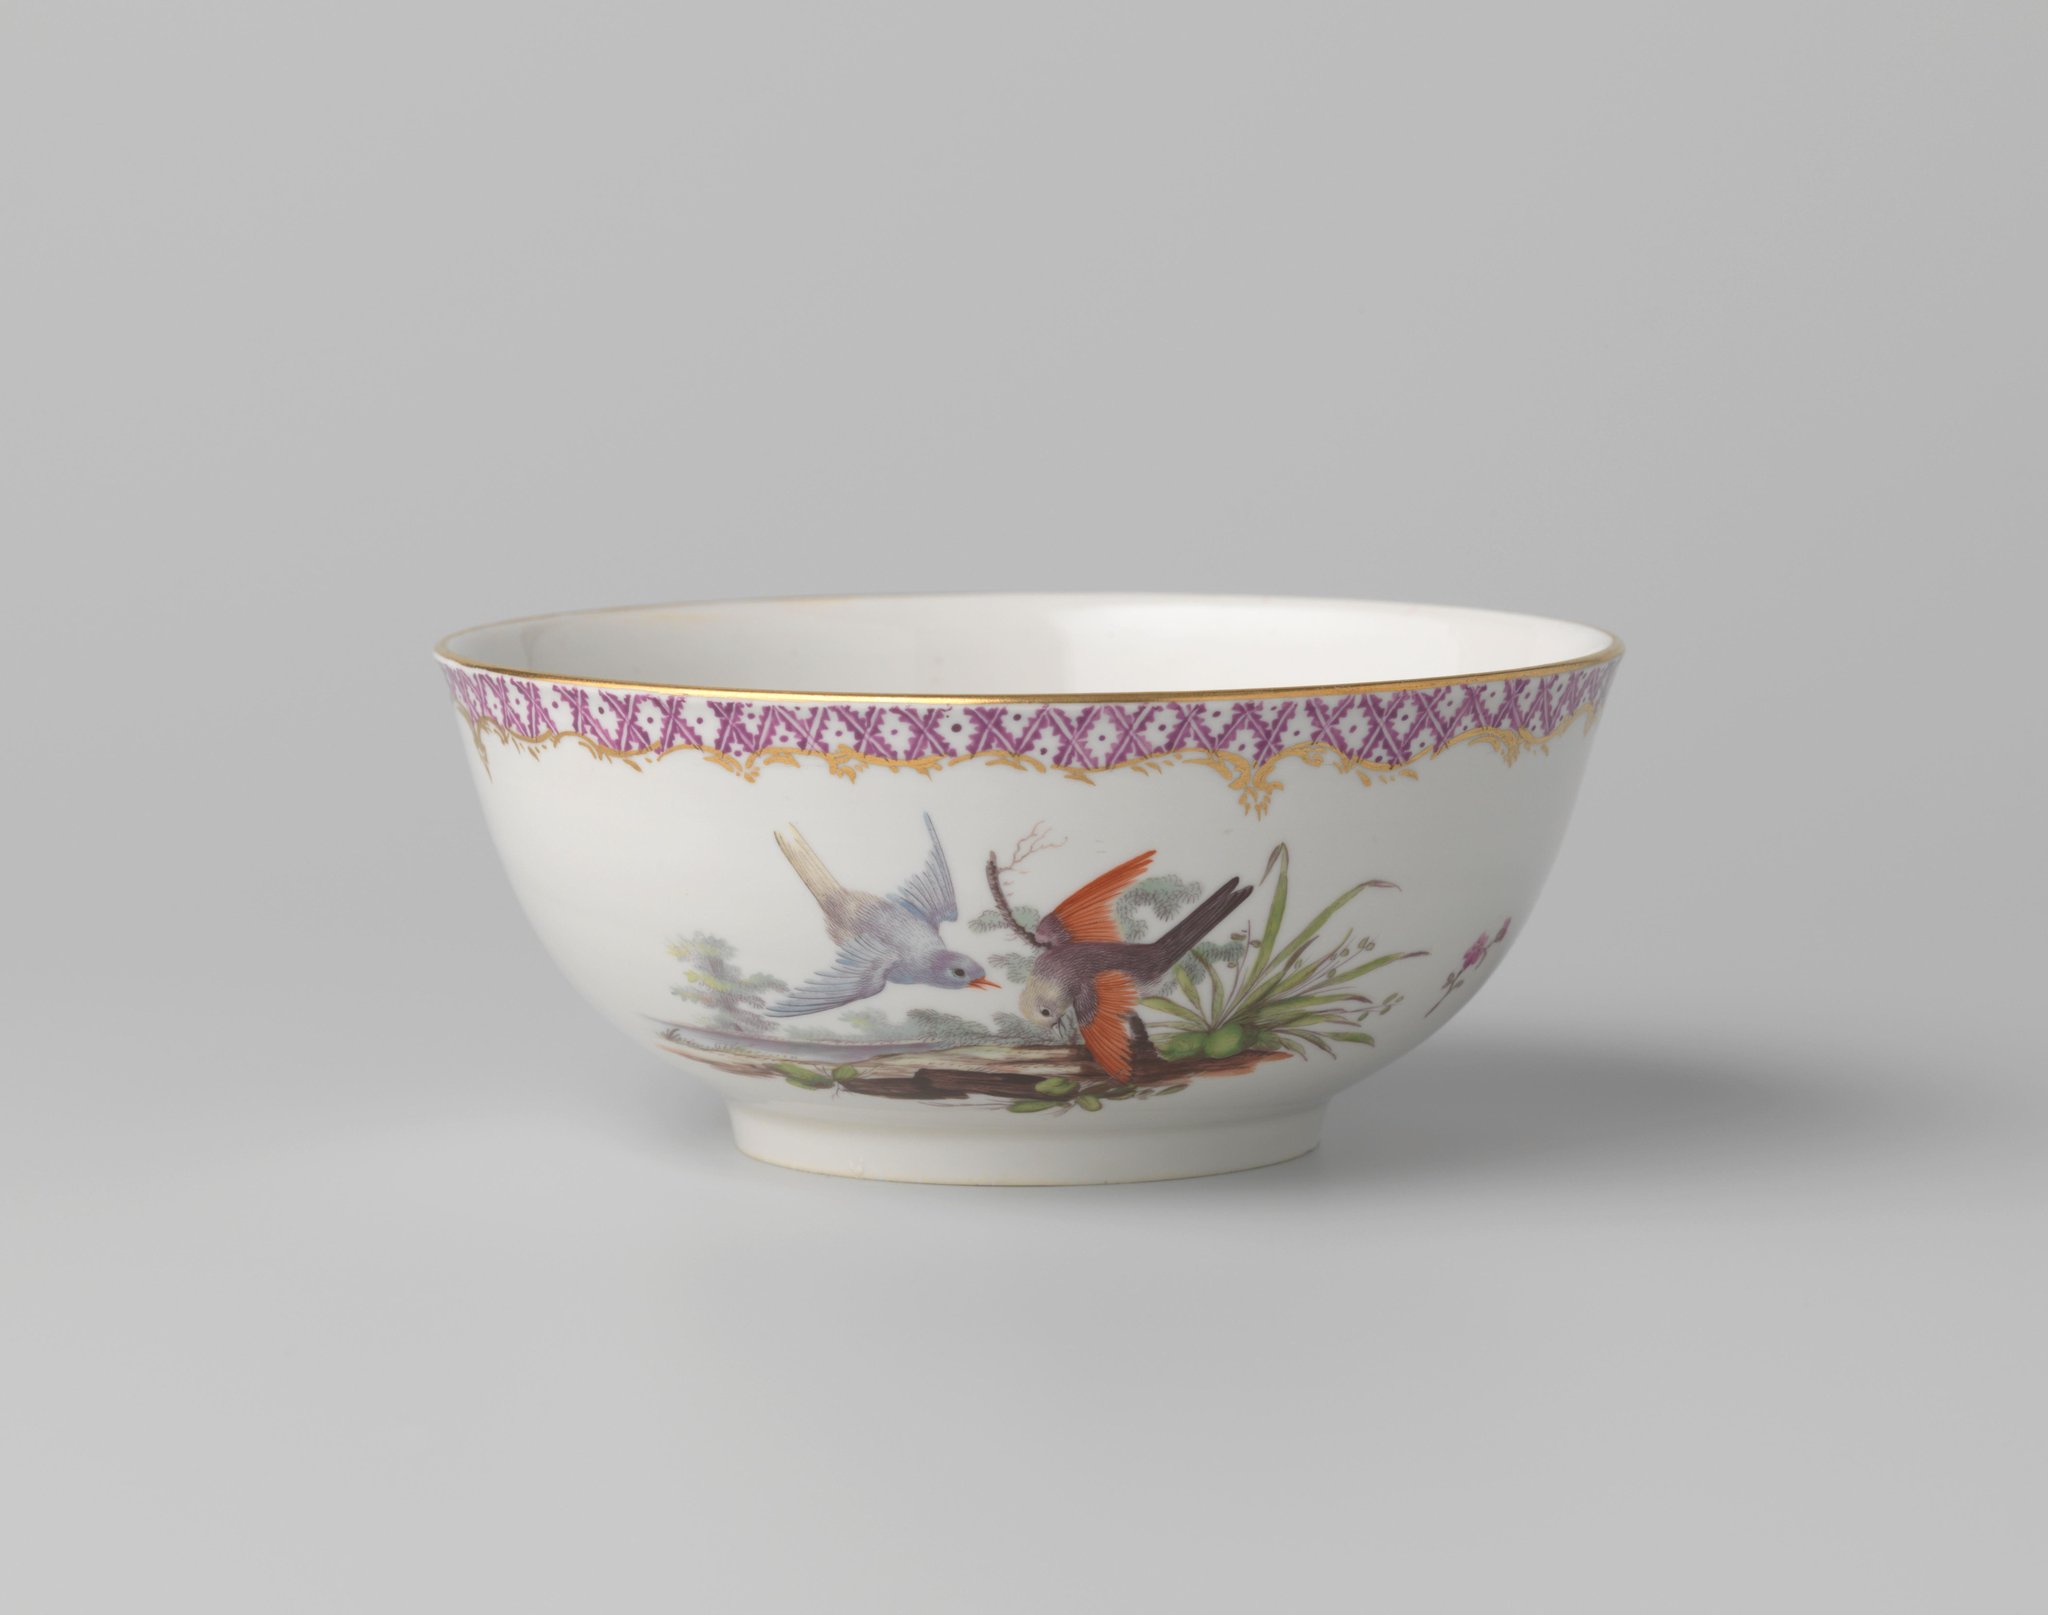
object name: slop bowl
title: Bowl with birds in a landscape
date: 1765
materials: glaze, gold, paint, porcelain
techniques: firing, forming, gilding, turning, vitrification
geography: ansbach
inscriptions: mark: ‘A/ I’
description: Spoelkom van porselein, beschilderd op het glazuur in emailkleuren en goud. Op de buitenwand tweemaal een voorstelling van vogels in een landschap. Op de buitenrand een band met servetwerk, waaronder gouden ranken. Op de bodem een boeket van verschillende bloemen. Gouden lijn op de rand. Gemerkt op de onderzijde met de A en I.